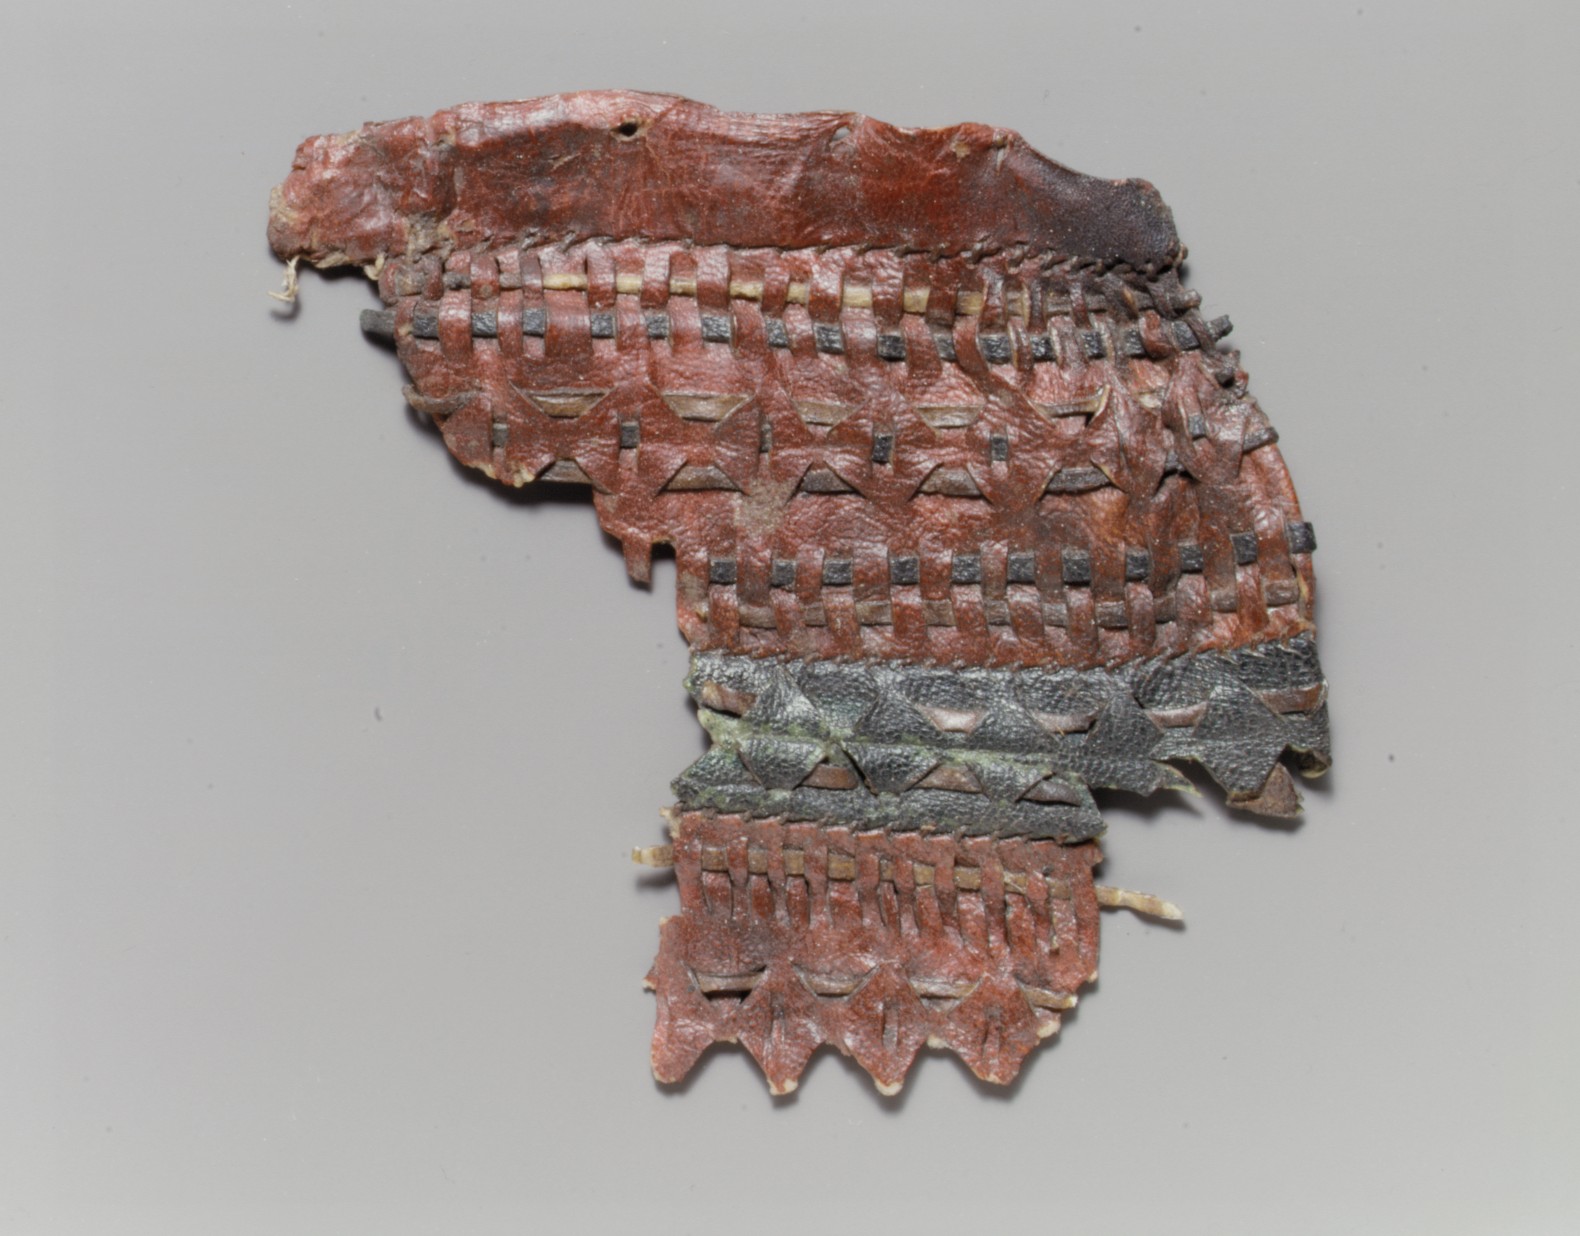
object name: quiver fragment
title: Fragment of a quiver (?)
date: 2124-1981 BCE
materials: dye, leather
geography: egypt